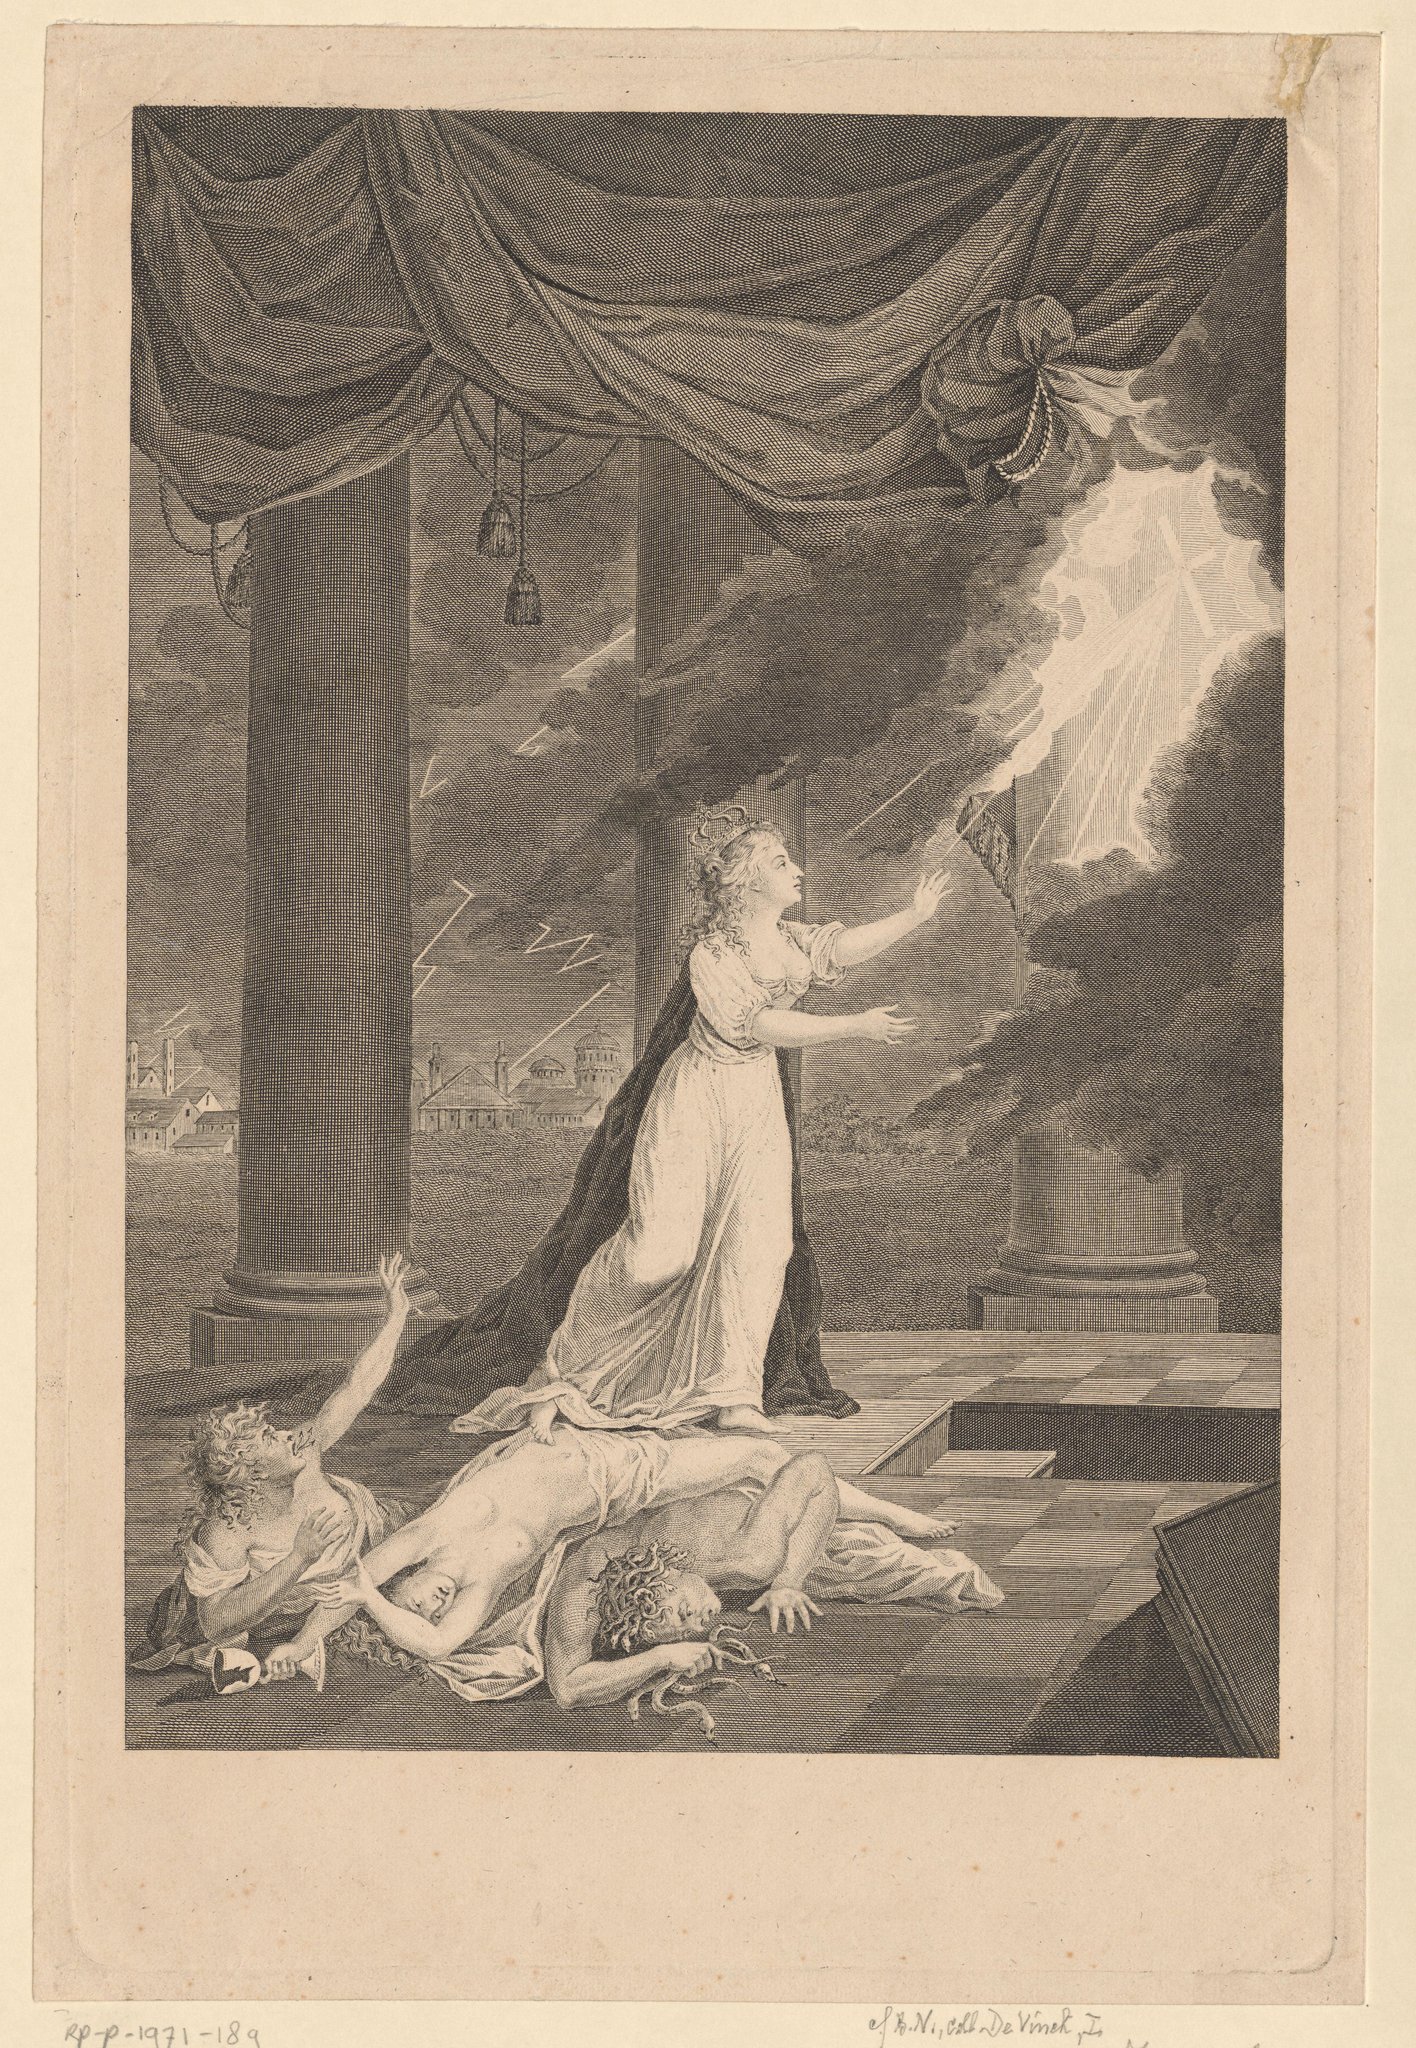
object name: print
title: Allegorie met Marie Antoinette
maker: Anonymous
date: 1774-1799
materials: paper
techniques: engraving, etching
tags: marie antoinette, lust, luxury, 'luxuria'; 'lussuria' (ripa) ~ personification of one of the deadly sins, envy; 'invidia' (ripa) ~ personification of one of the seven deadly sins, historical persons - bb - woman, lightning, flash of lightning, thunderbolt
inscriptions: collector's mark: Lugt 2228, collector's mark: Lugt 2760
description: Marie Antoinette met een kroon op staat op drie verschillende personificaties, waaronder Afgunst (Invidia) en mogelijk Lust (Luxuria). Marie Antoinette kijkt op naar een stralend kruis in de hemel. Links in de achtergrond onweer boven een stad.